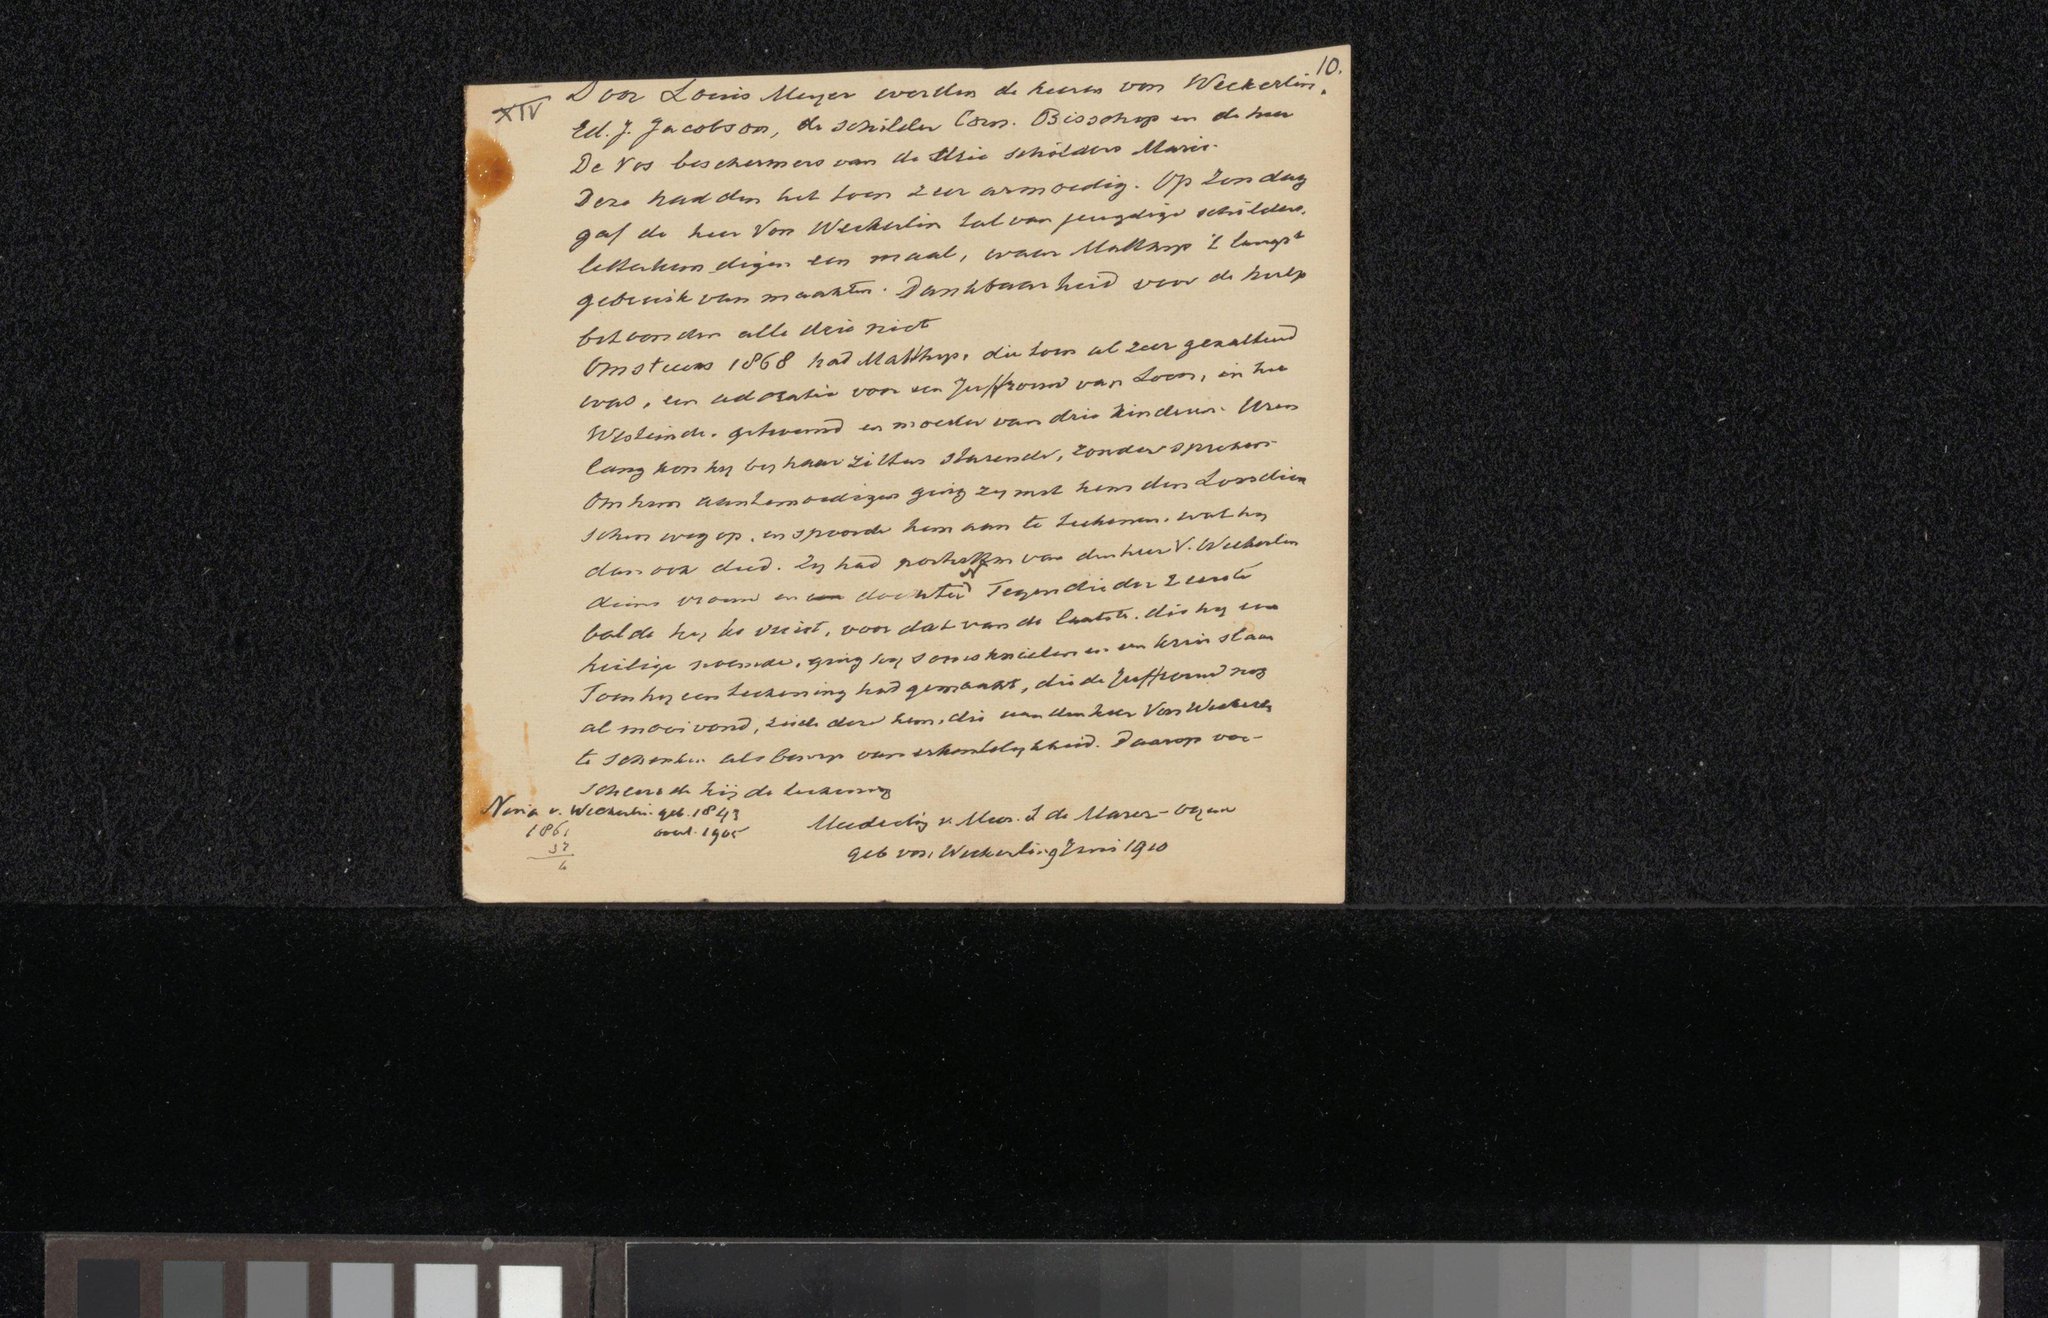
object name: aantekening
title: Aantekening betreffende Matthijs Maris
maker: pieter haverkorn van rijsewijk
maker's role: museumdirecteur, publicist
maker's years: 1839-1919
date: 1910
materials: ink, paper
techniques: pen, writing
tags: the hague, london, painter, print maker, draughtsman, matthijs maris, nina van weckerlin, drawing, passions, emotions, affections